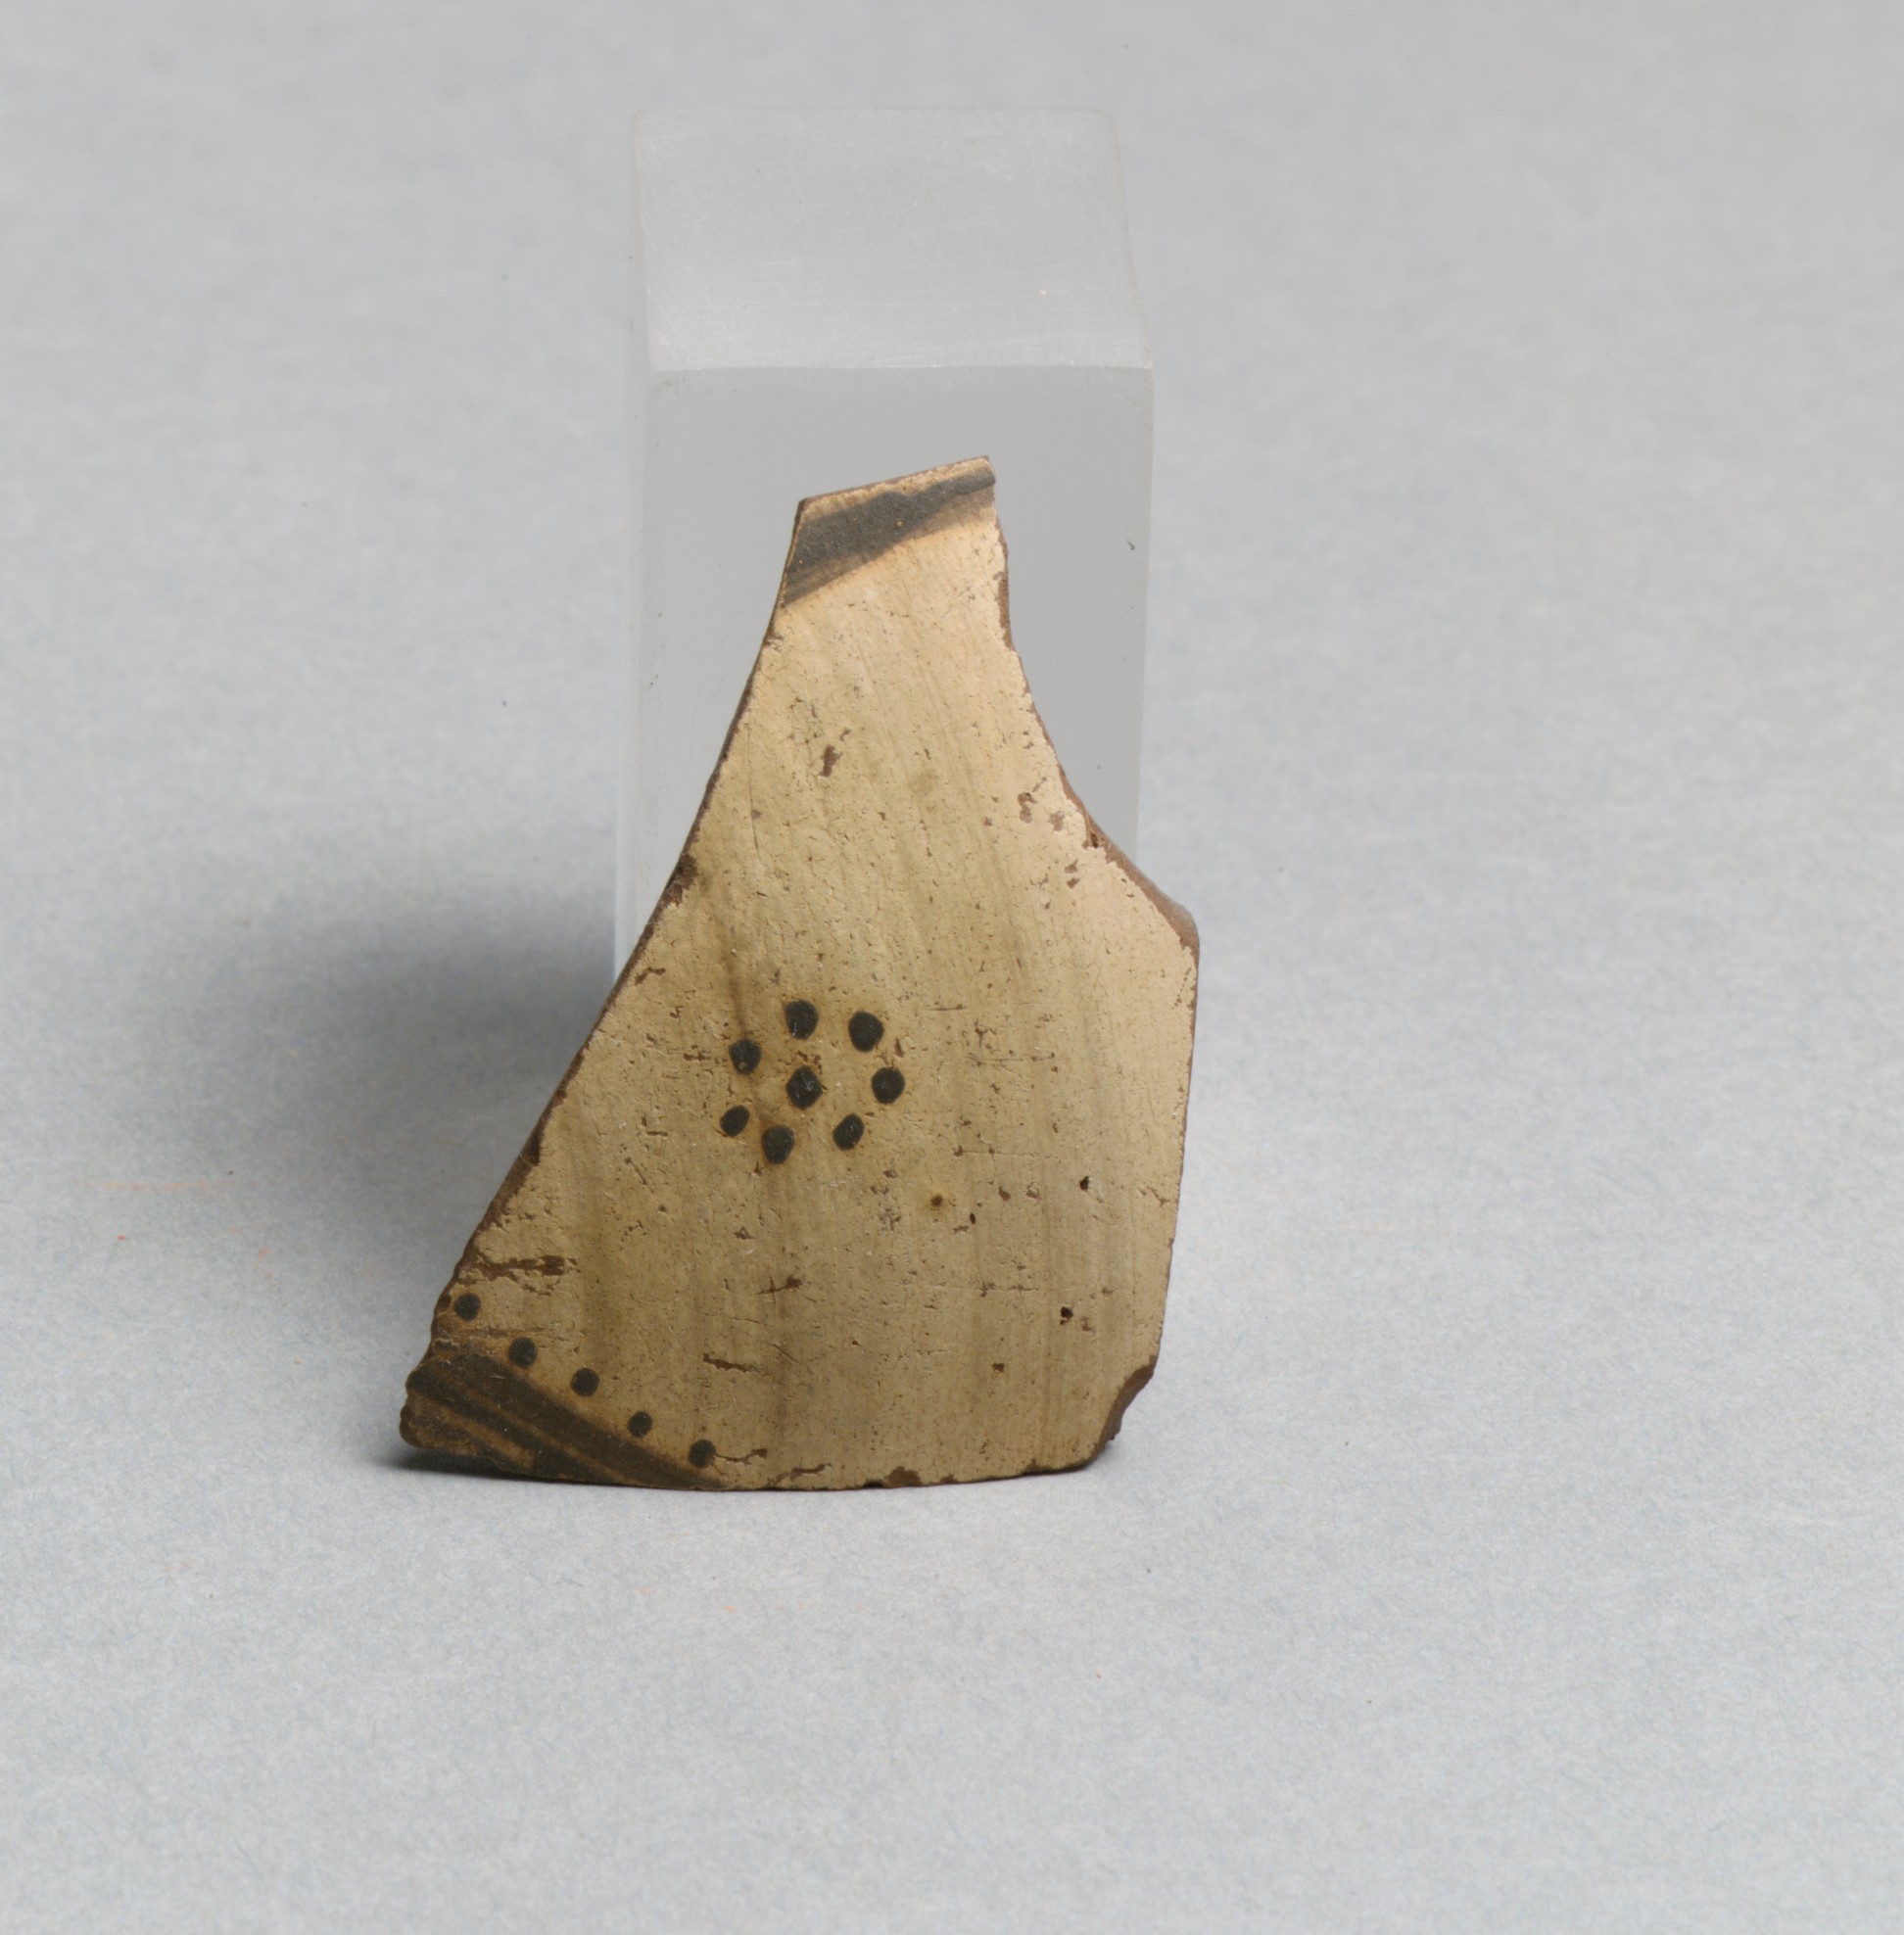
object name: skyphos fragment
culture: greek or lydian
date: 900-30 BCE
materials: terracotta